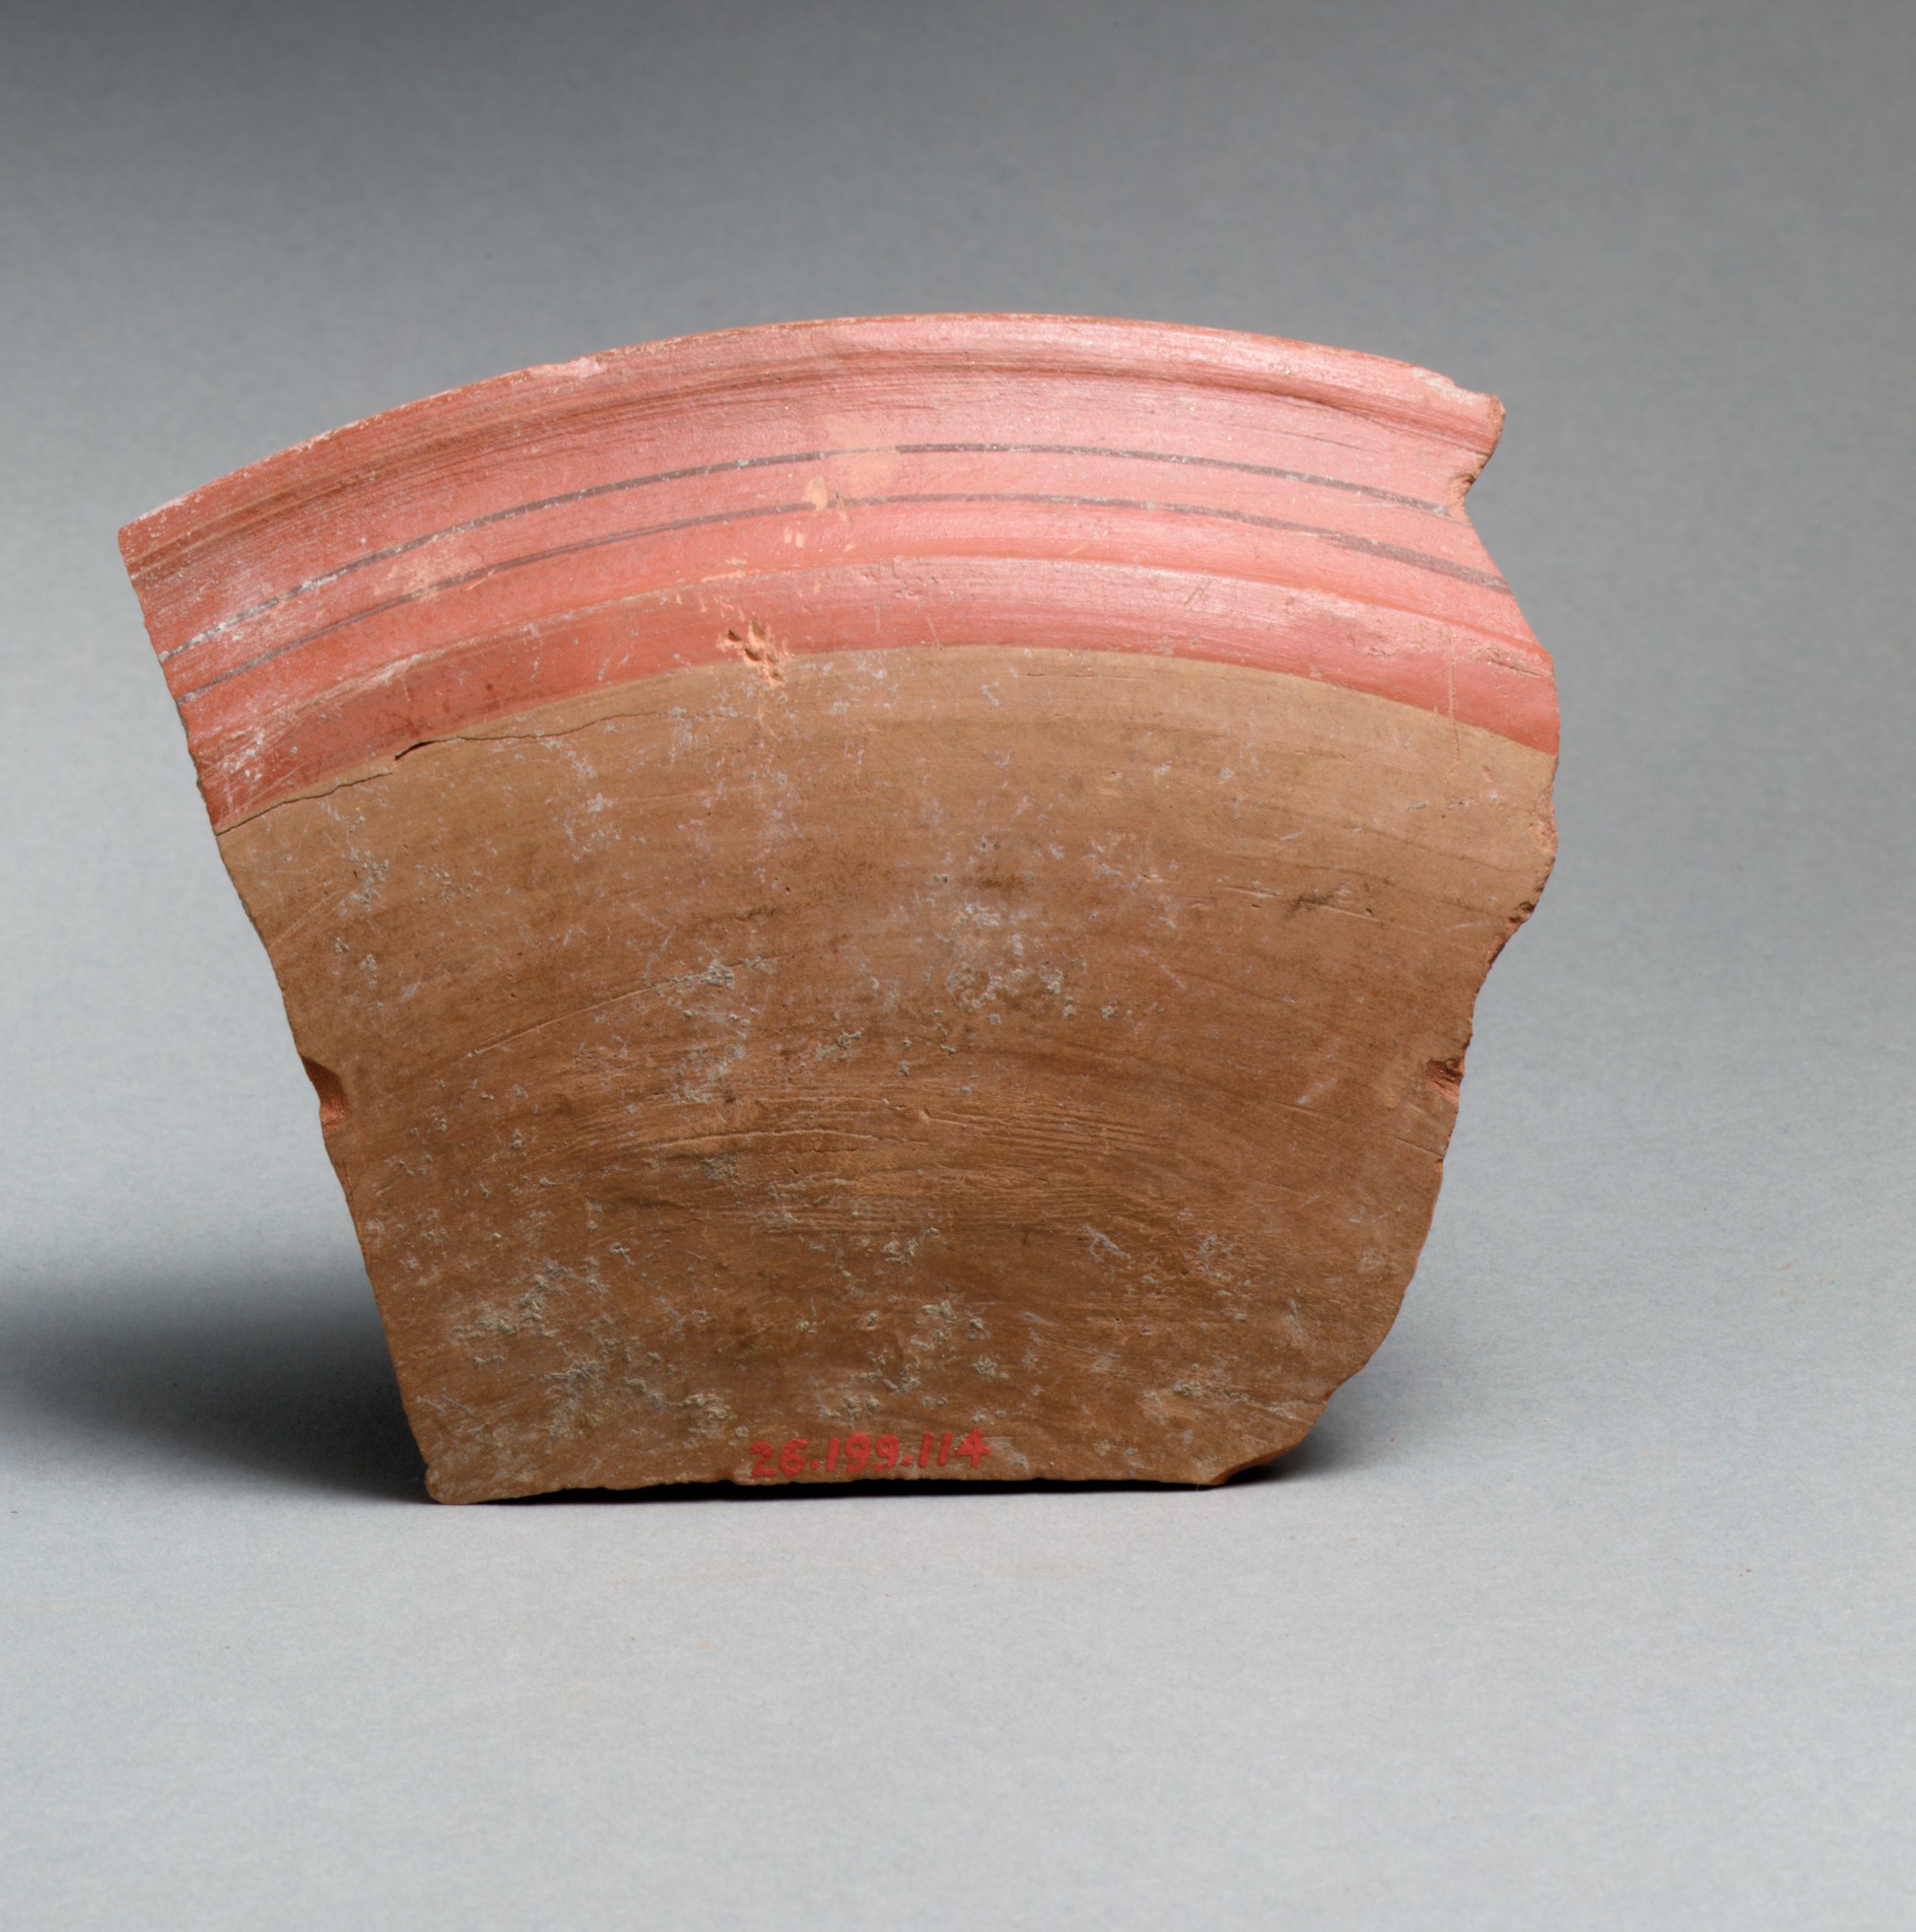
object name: vase fragment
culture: greek or lydian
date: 800-480 BCE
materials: terracotta